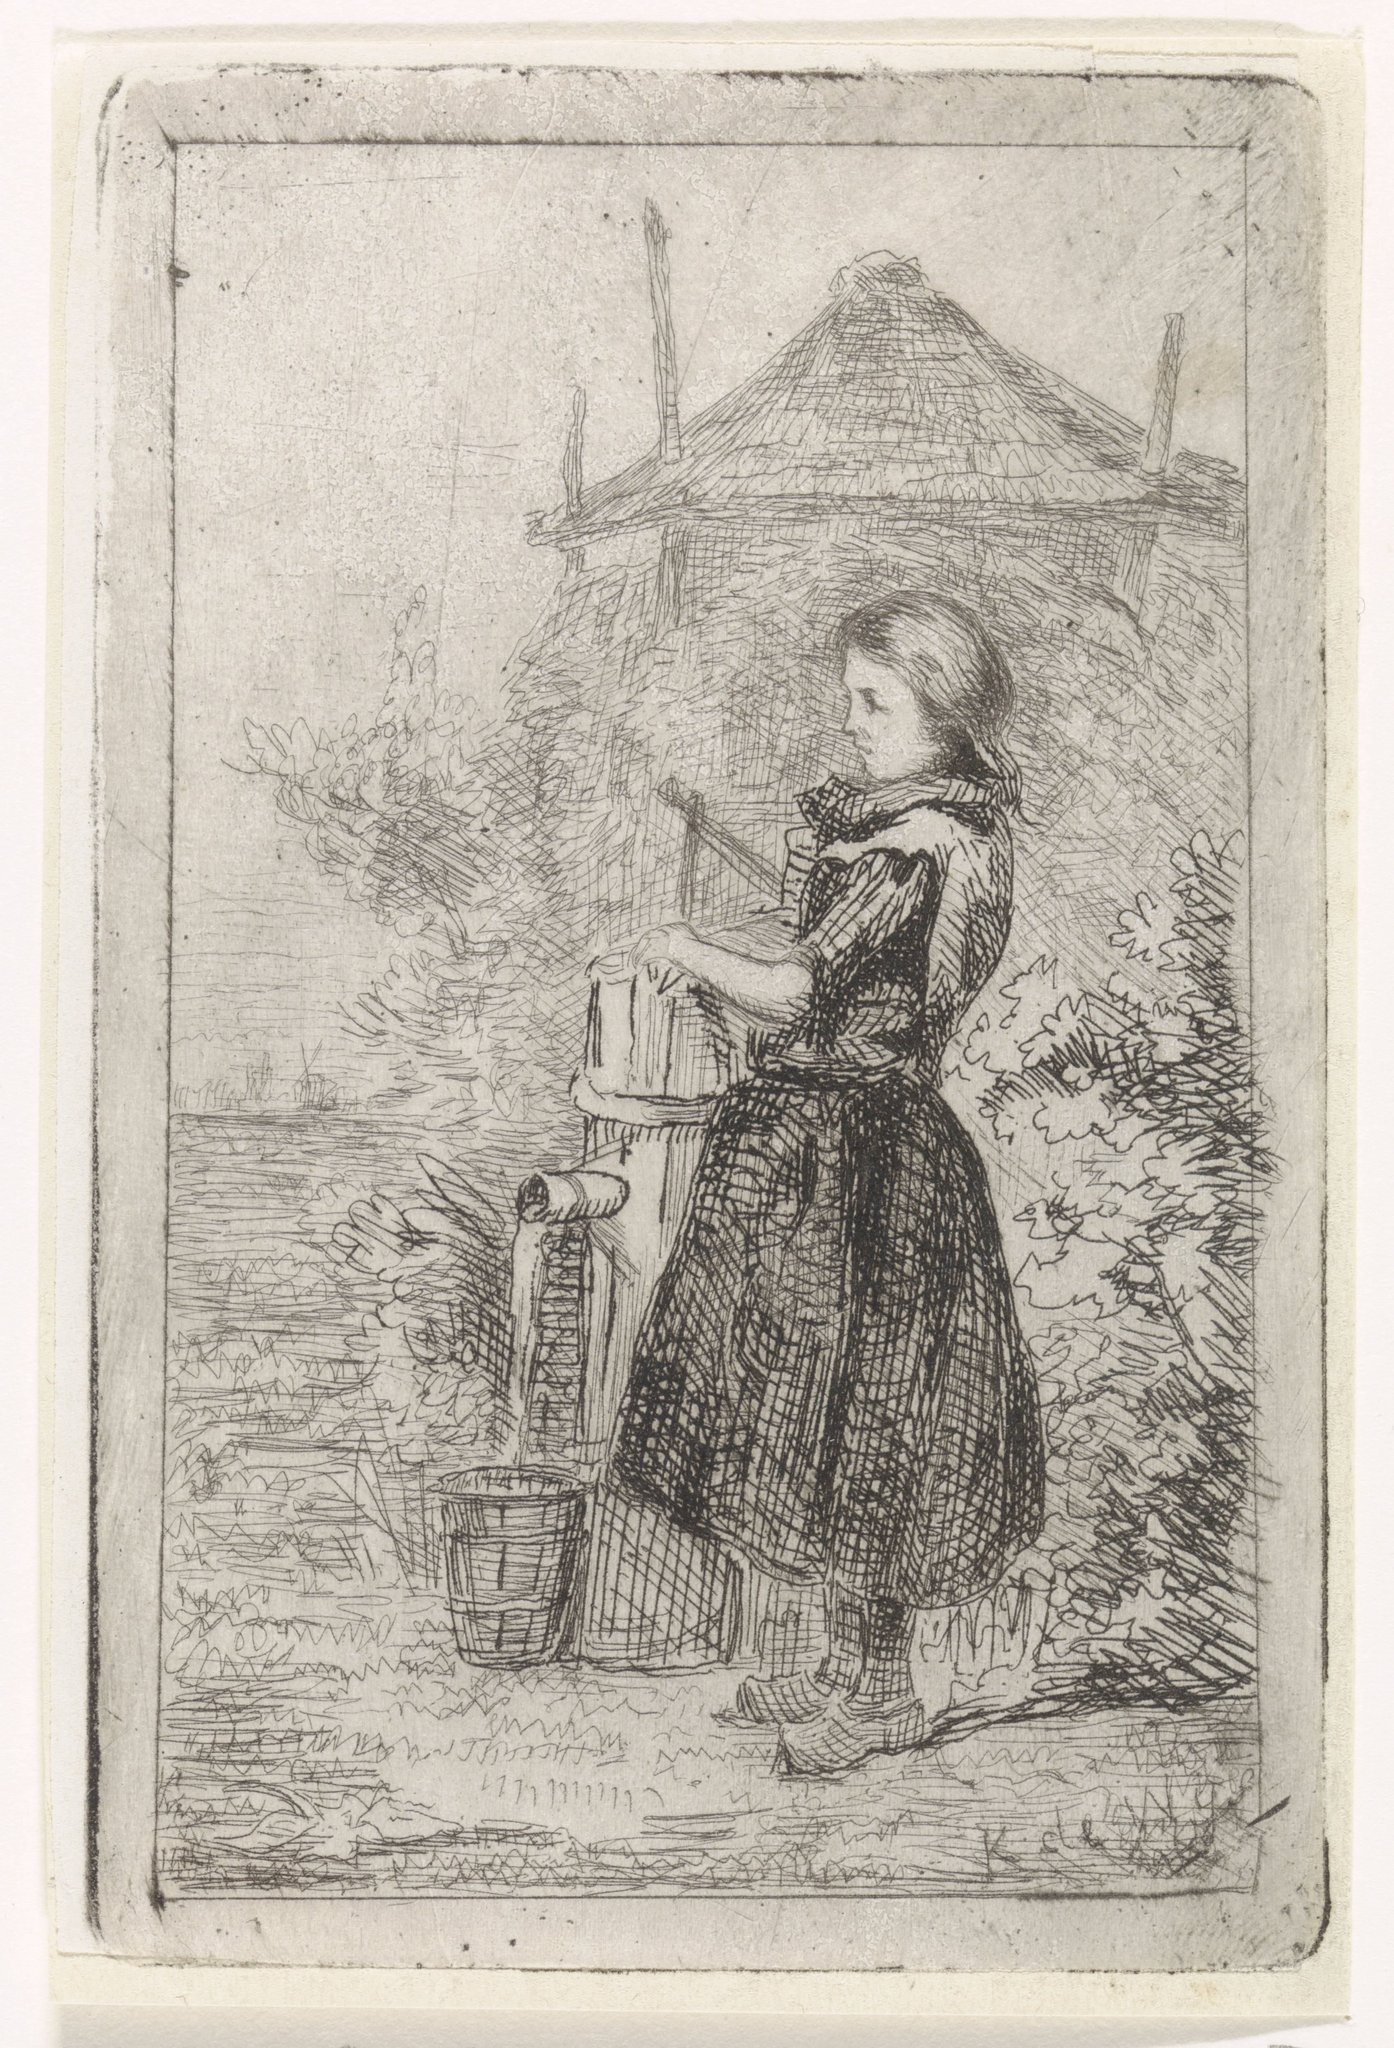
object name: print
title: Meisje bij een waterpomp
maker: kornelis jzn de wijs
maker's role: print maker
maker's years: 1832-1896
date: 1842-1884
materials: paper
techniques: etching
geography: netherlands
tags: girl (child between toddler and youth), utilitarian, public pump or water fountain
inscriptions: collector's mark: Lugt 2228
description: Een meisje bij een waterpomp. Op de achtergrond een hooiberg.